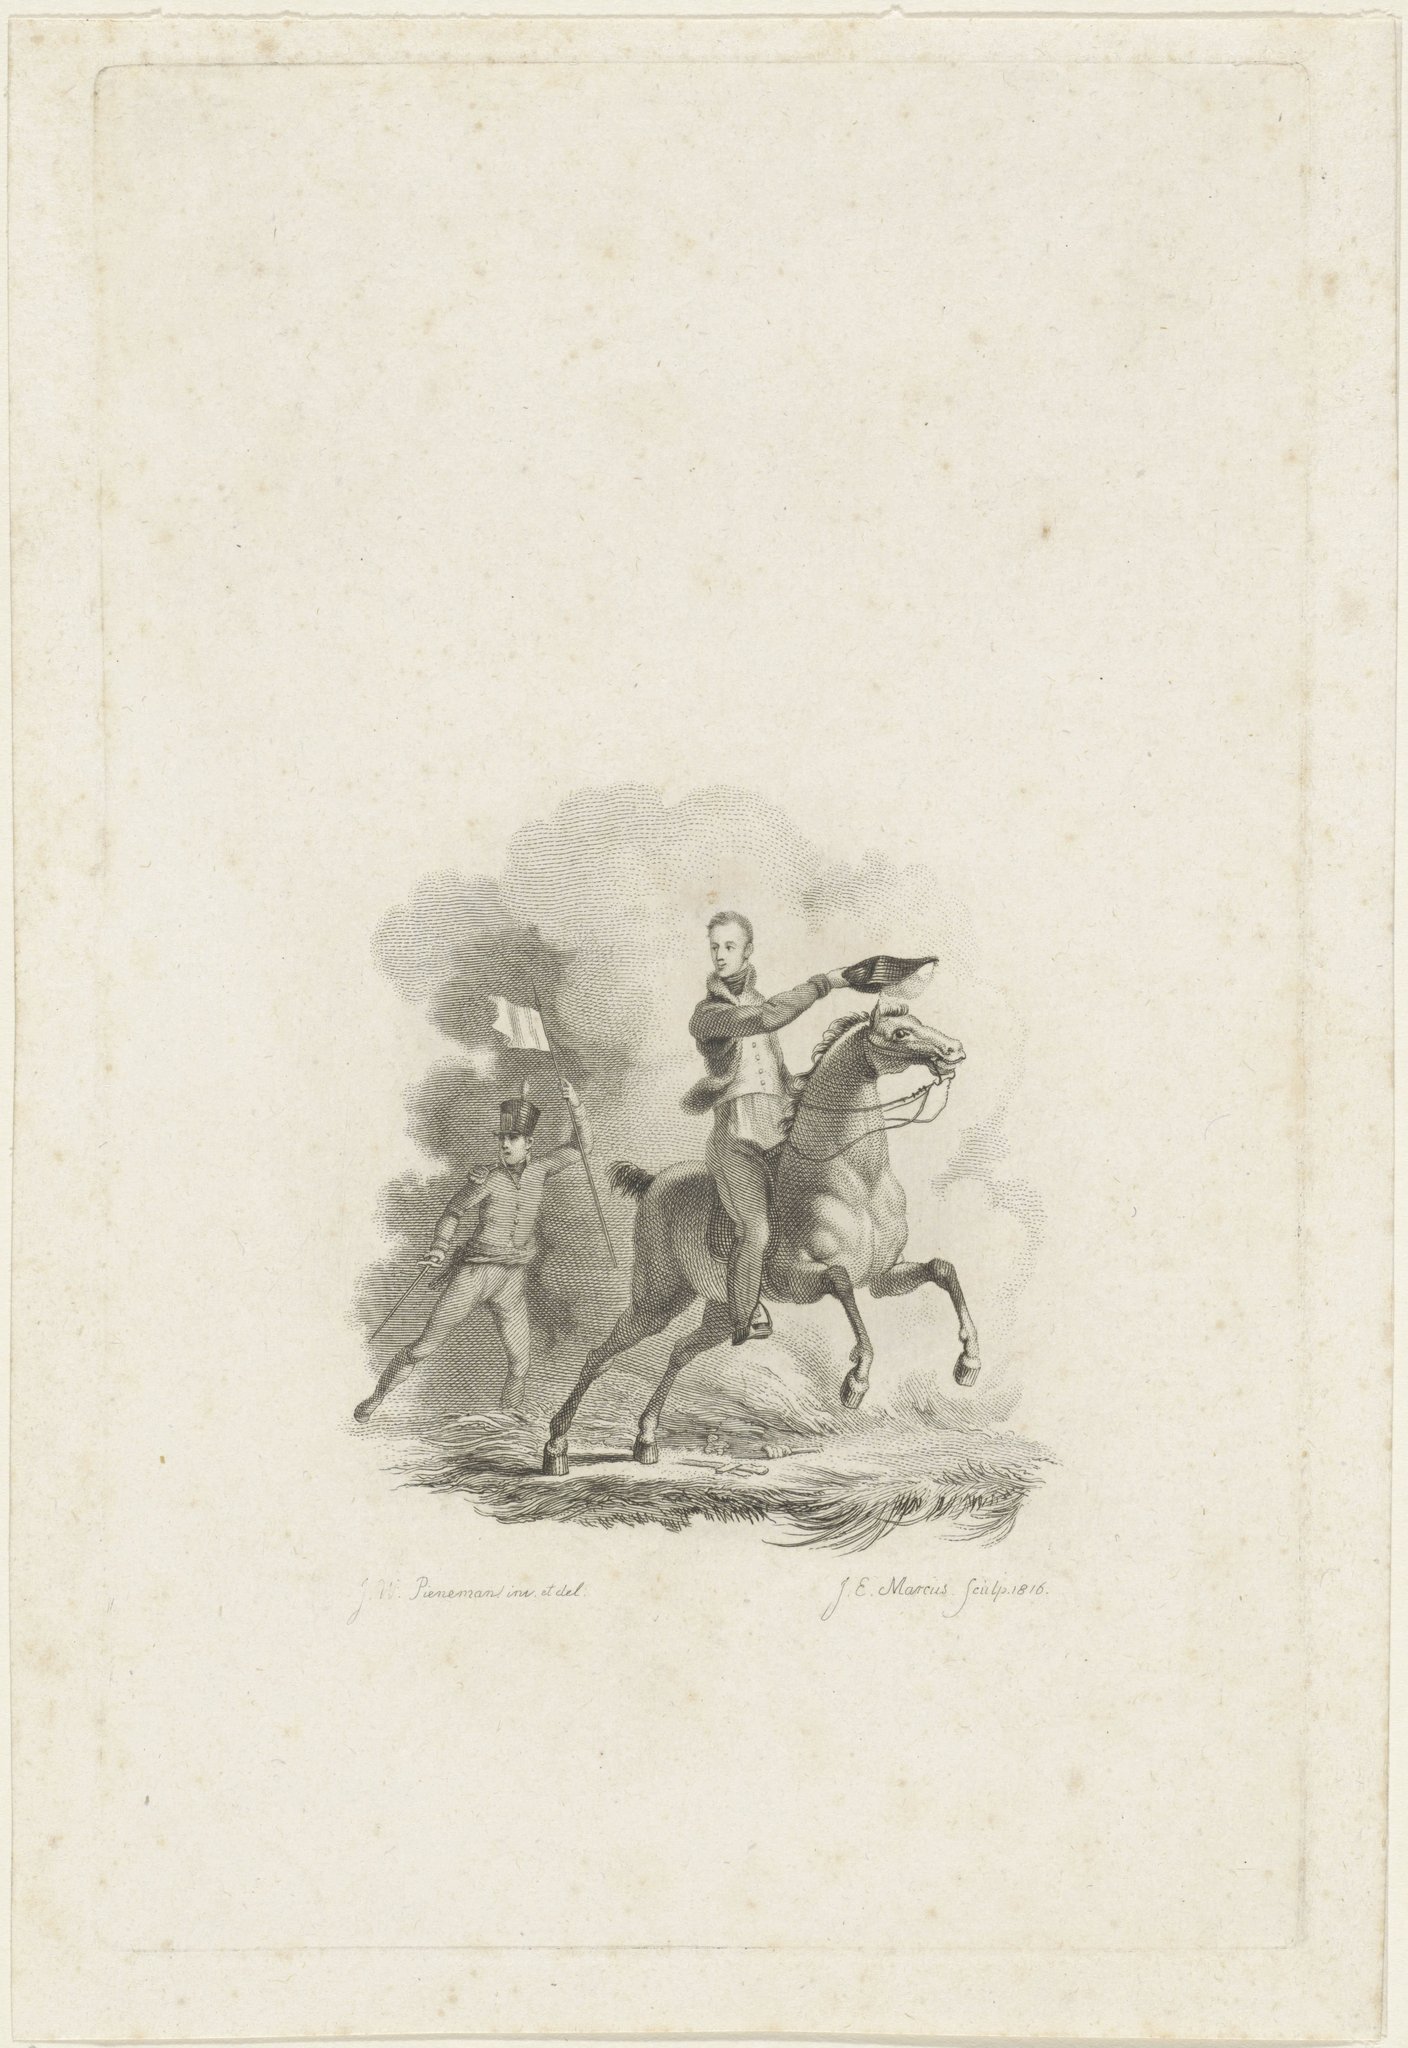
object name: print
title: Ruiterportret van Willem II, koning der Nederlanden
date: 1816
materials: paper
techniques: engraving, etching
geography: amsterdam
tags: the hague, william ii of the netherlands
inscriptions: date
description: De hier vermelde titel verwijst naar de hoogst verkregen titel van de geportretteerde, niet per se naar de titel die de geportretteerde op deze voorstelling draagt.